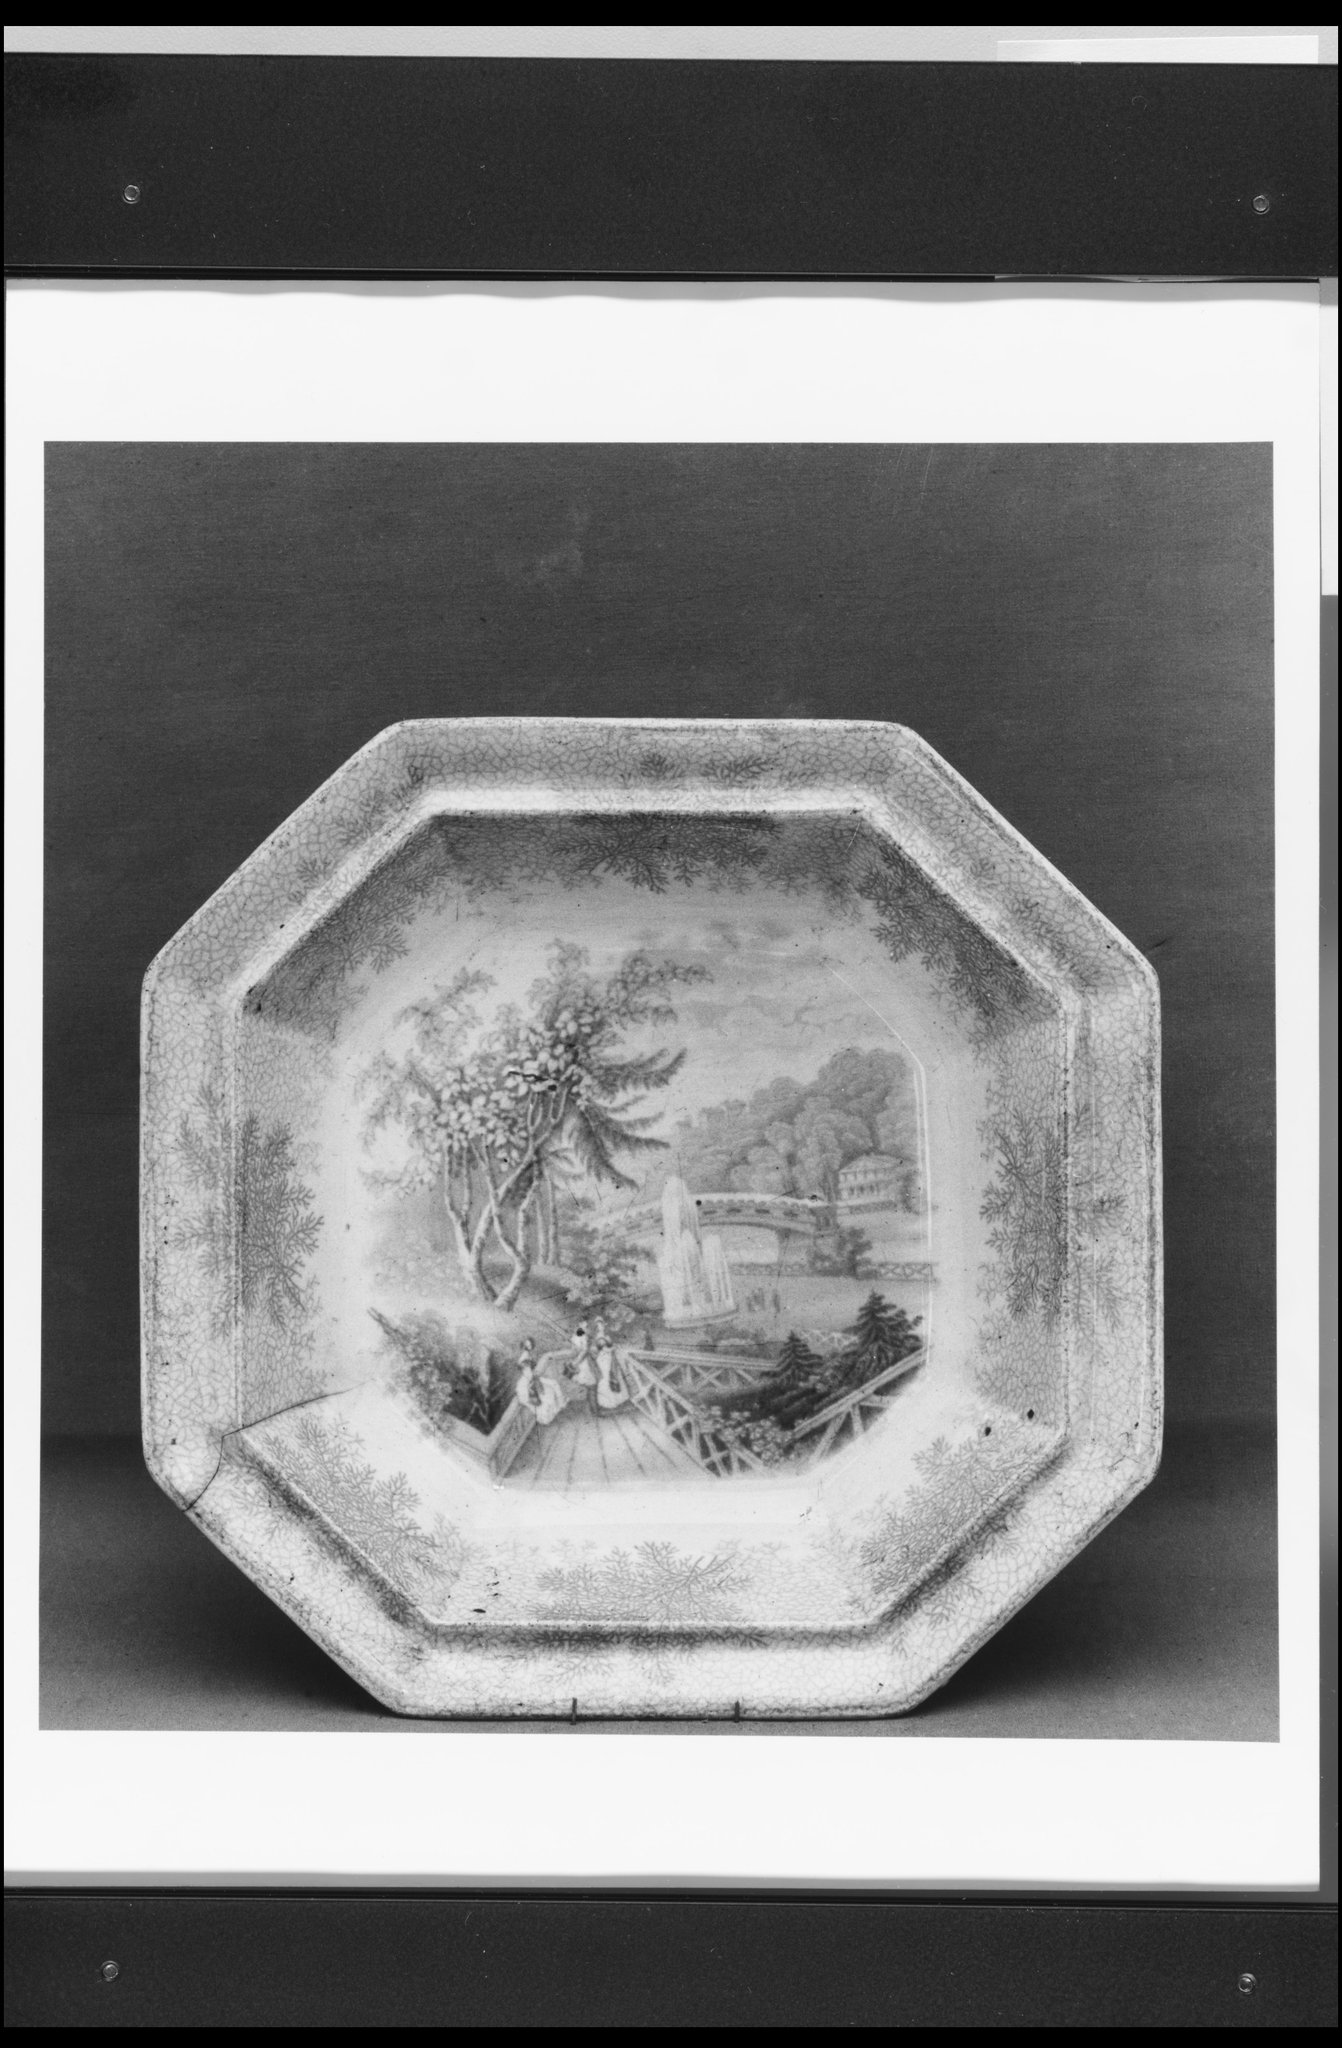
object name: dish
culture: british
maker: william ridgway, son & co.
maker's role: maker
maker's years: 1833-1848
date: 1844-1846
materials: earthenware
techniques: transfer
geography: england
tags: bridges,trees